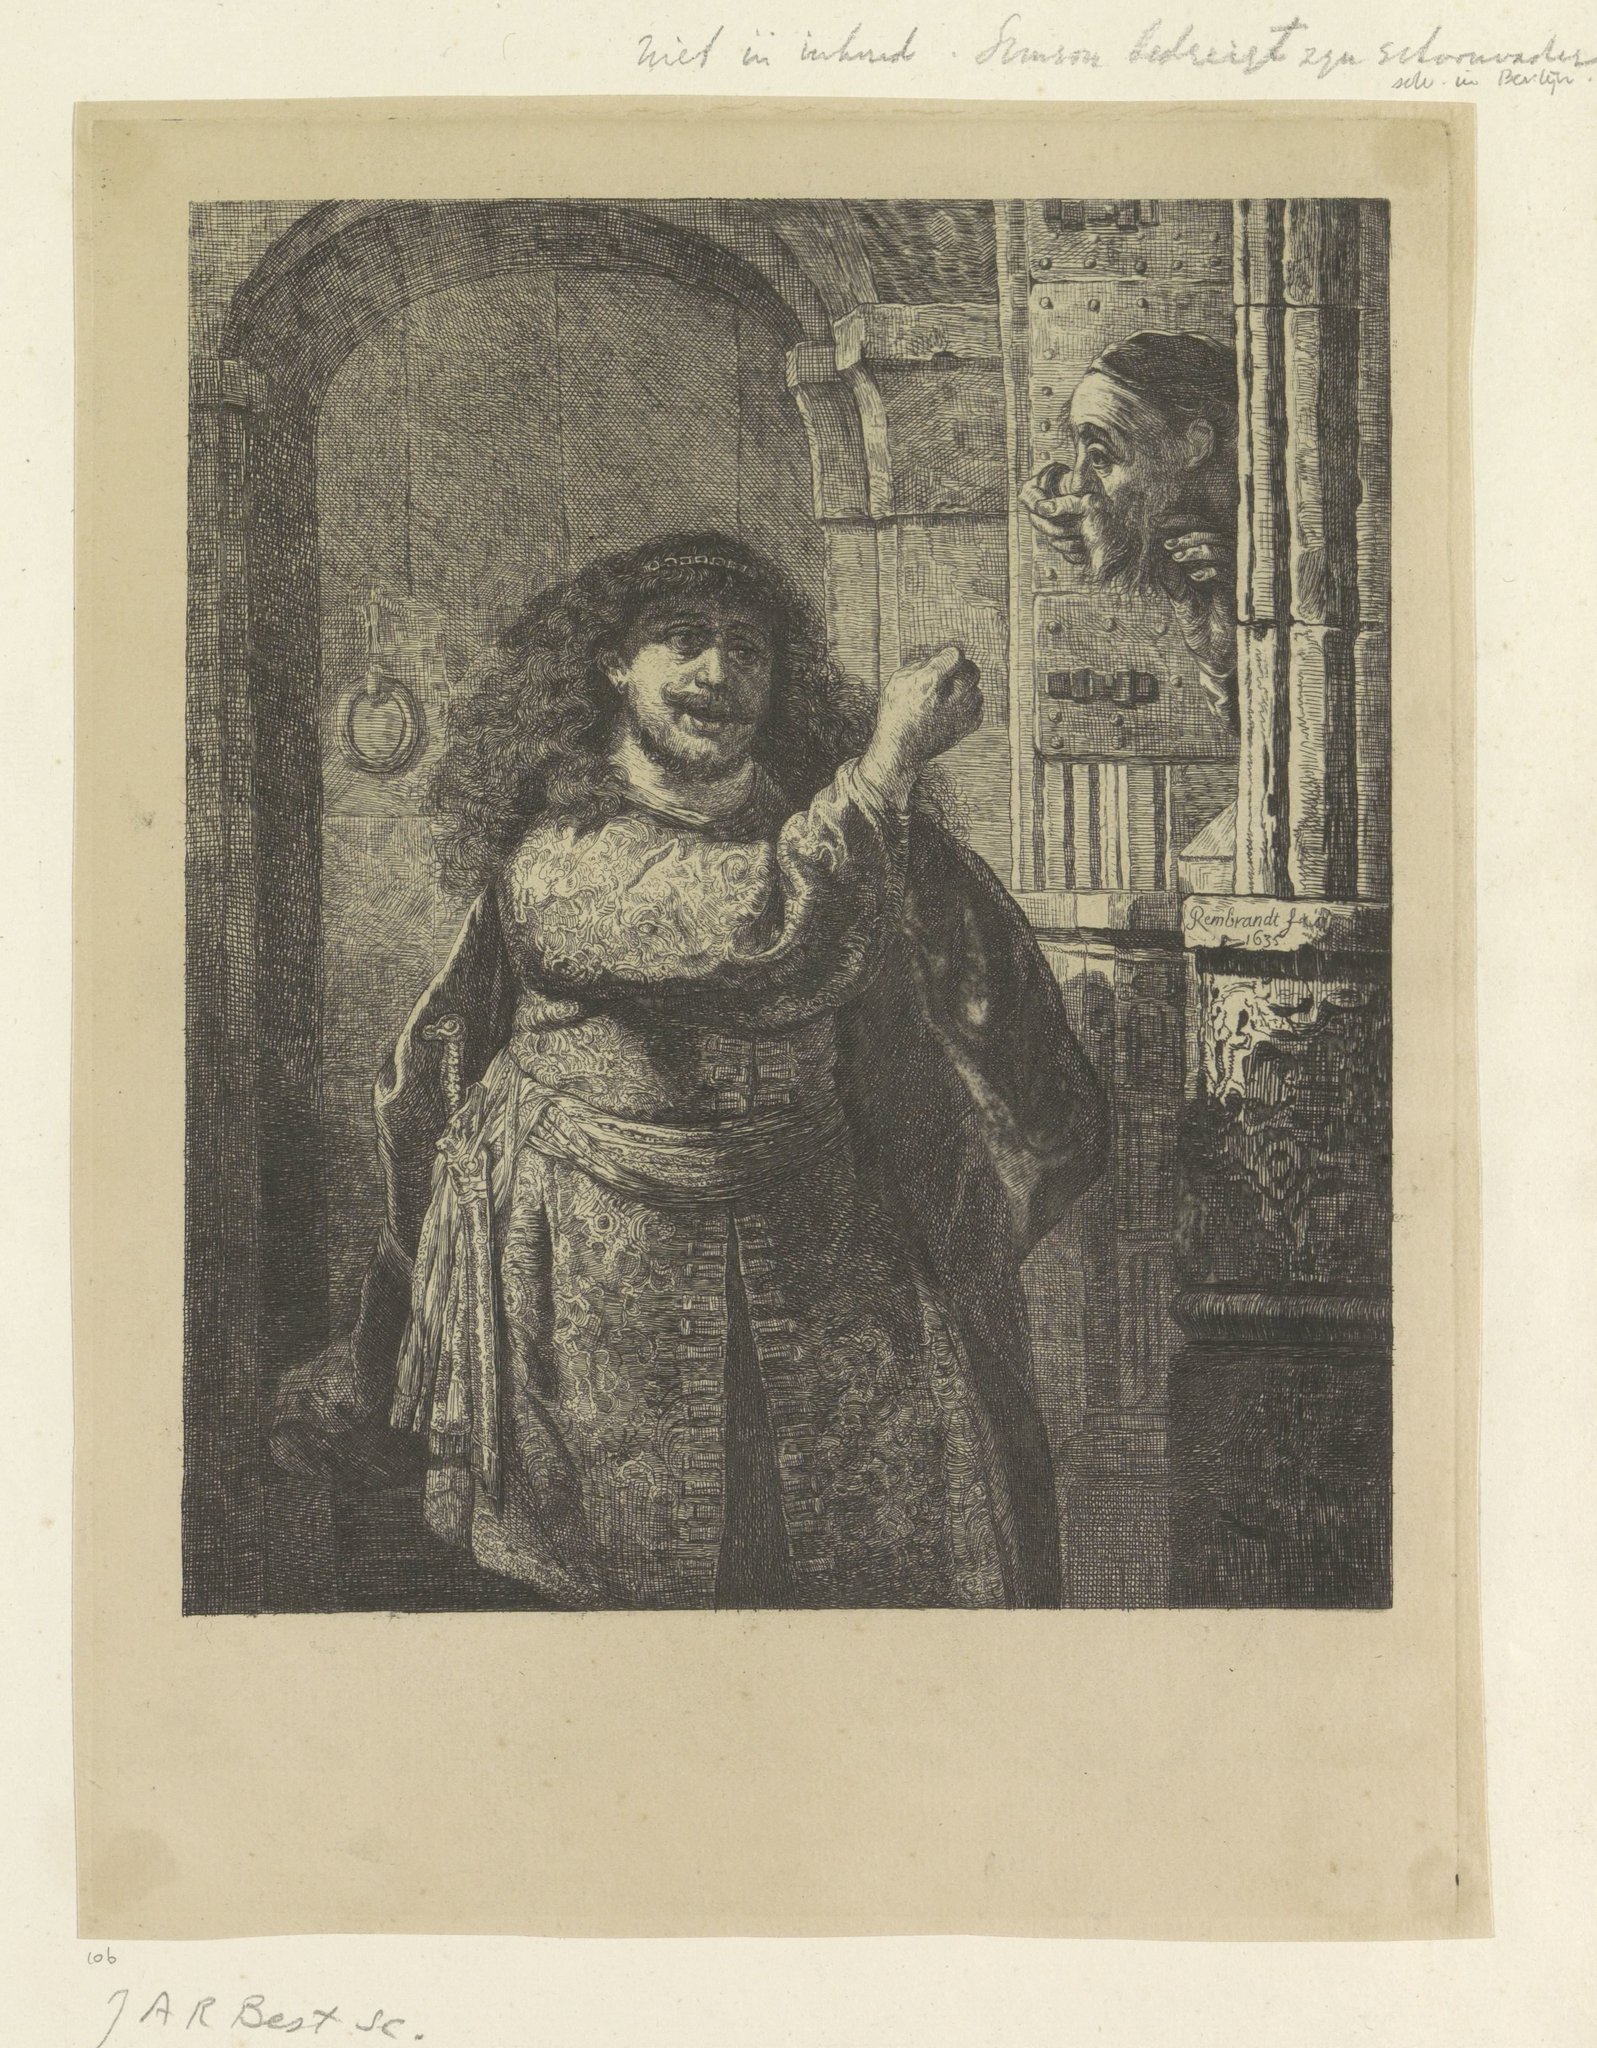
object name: print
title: Samson beschuldigt zijn schoonvader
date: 1756-1807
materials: paper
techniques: etching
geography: paris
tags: the time of samson ~ the book of judges